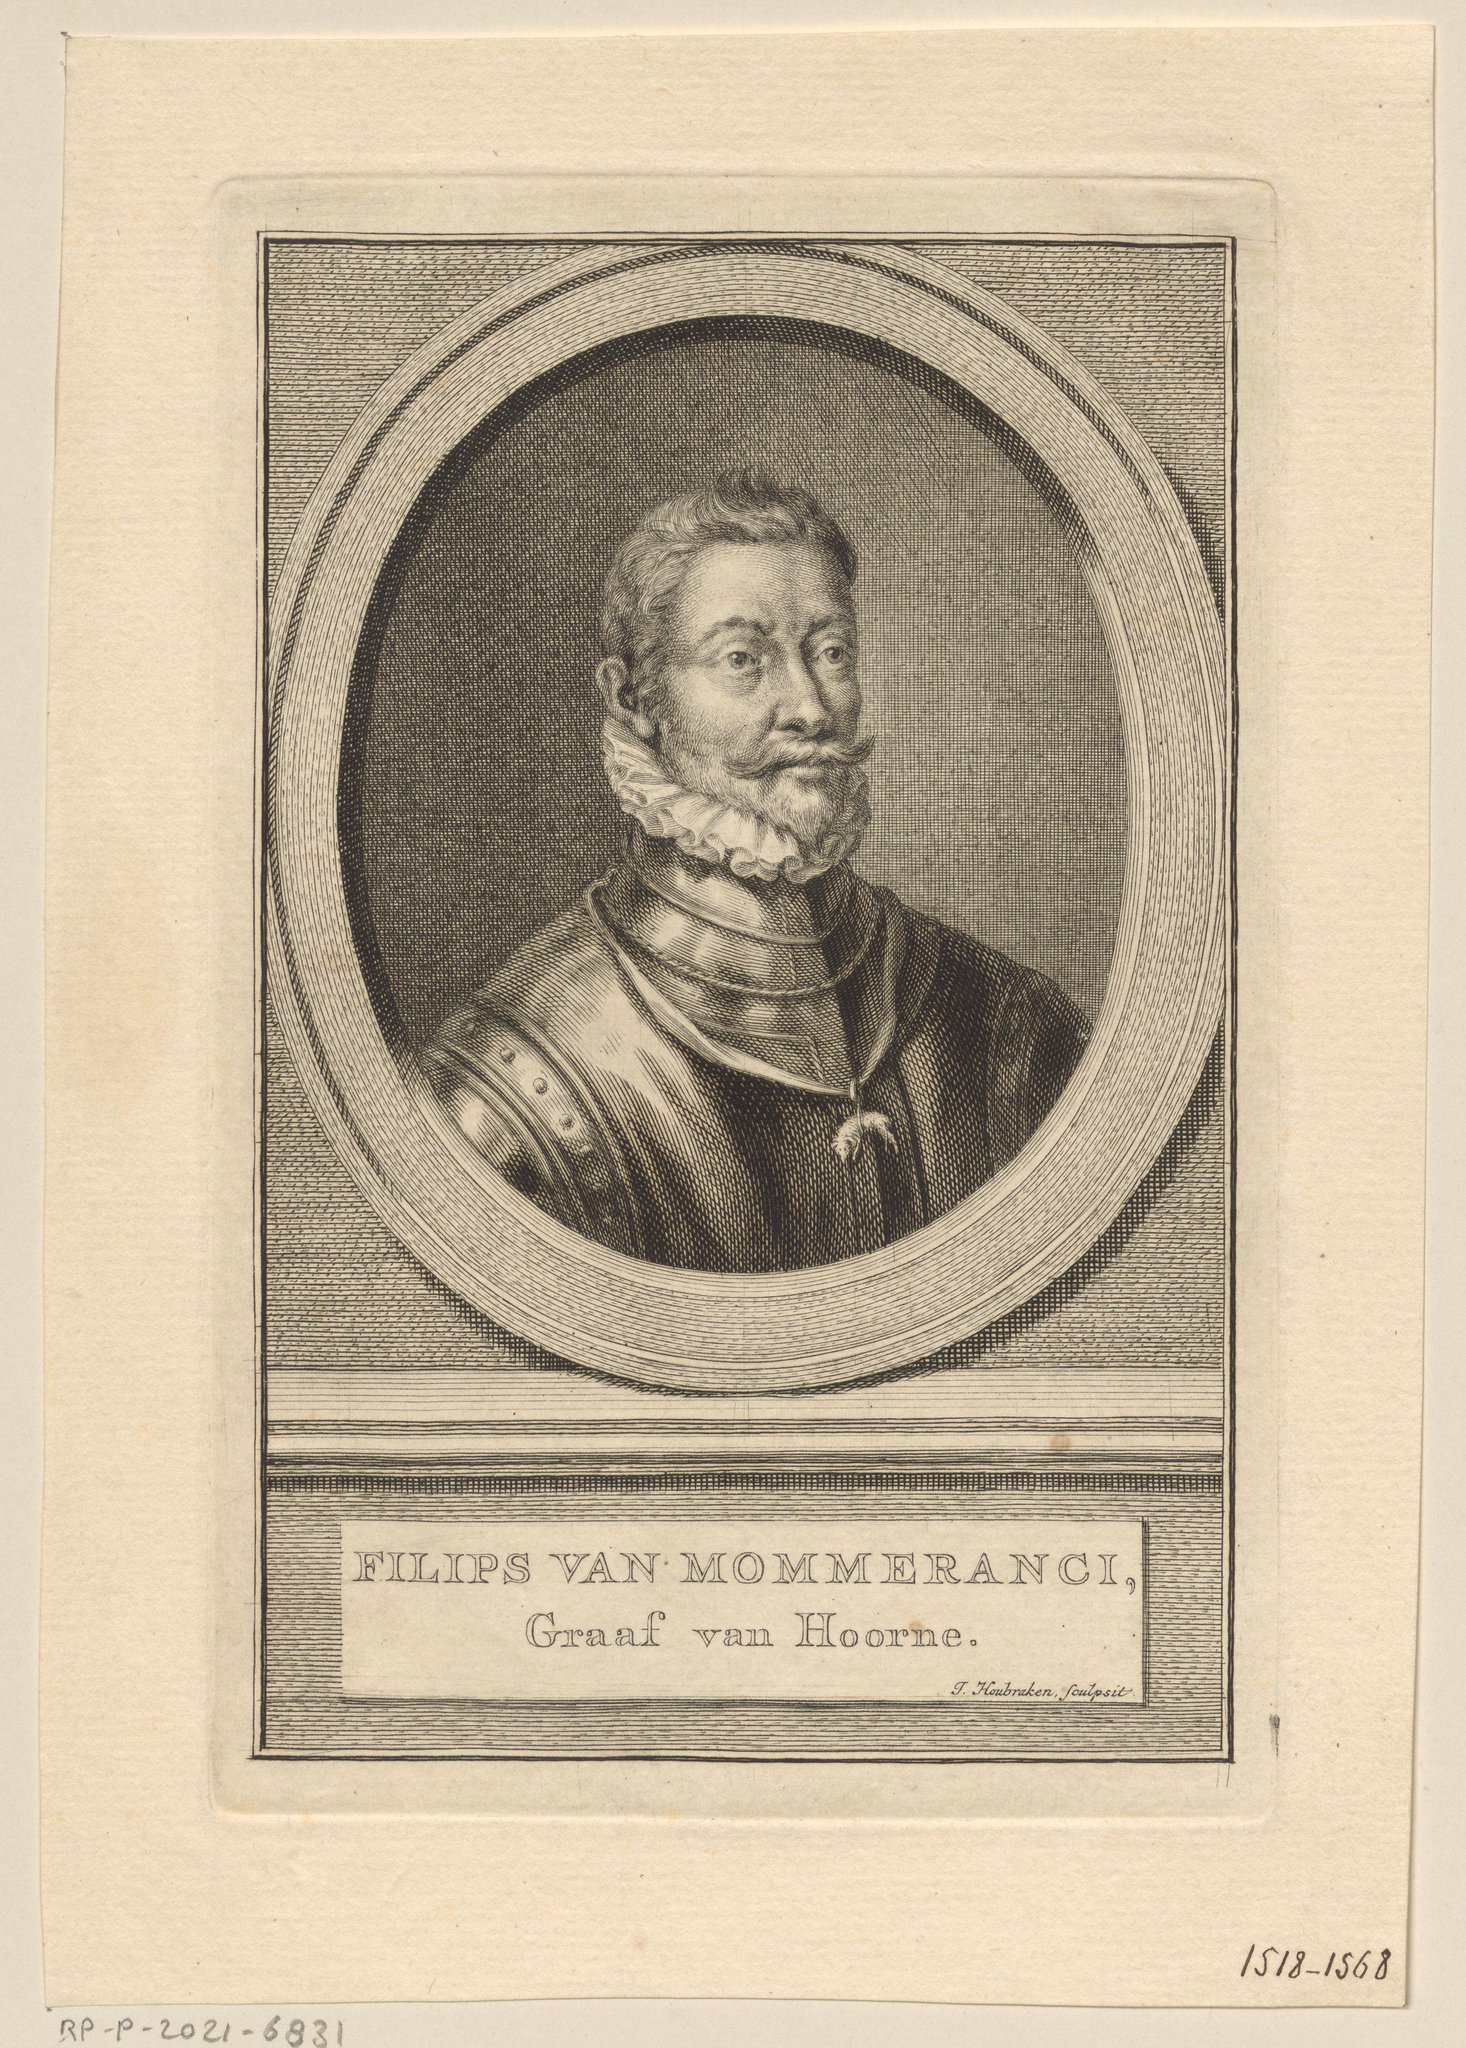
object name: book illustration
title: Portret van Filips van Montmorency, graaf van Horne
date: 1749-1759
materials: paper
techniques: engraving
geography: amsterdam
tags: brussels, armour, historical persons, knighthood order of the golden fleece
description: Prent oorspronkelijk bedoeld als aanvulling op: Wagenaar, Jan. Vaderlandsche historie, vervattende de geschiedenissen der Vereenigde Nederlanden (…). 21 dln. Amsterdam: Isaak Tirion, 1749-1759 (eerste editie). De portretten werden echter pas toegevoegd bij de 1796-editie door Johannes Allart: Wagenaar, Jan. Vaderlandsche historie, vervattende de geschiedenissen der nu Vereenigde Nederlanden (…). 21 dln. Amsterdam: Johannes Allart, 1790-1796.